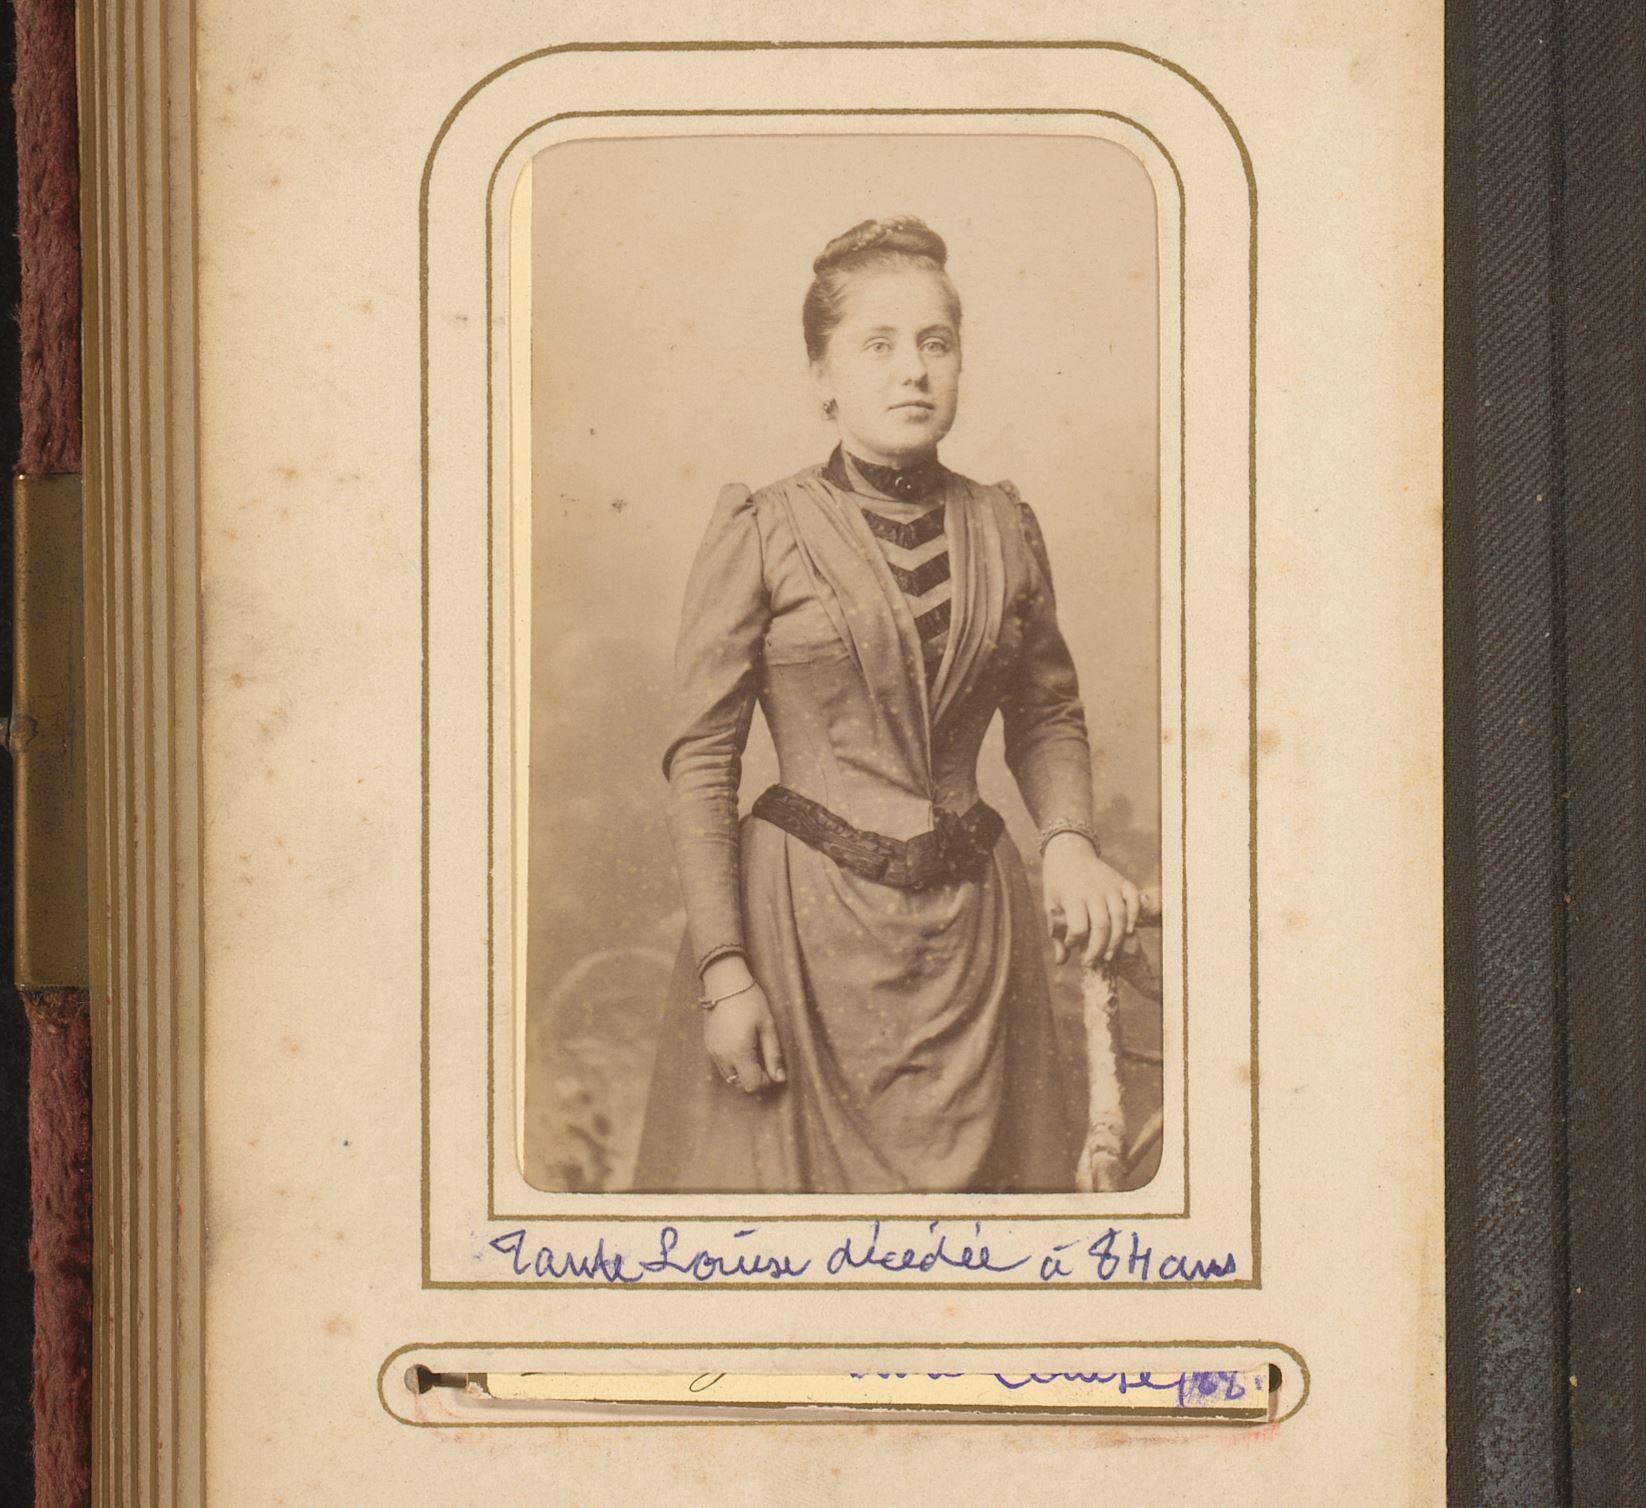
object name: album leaf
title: Portret van een jonge vrouw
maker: christian meyer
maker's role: fotograaf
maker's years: 1835-1910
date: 1860-1900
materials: cardboard, photographic support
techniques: albumen print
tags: adolescent, young woman, maiden, historical persons, standing figure - aa - female human figure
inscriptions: inscription: ‘Photographische Anstalt/ Chr. Meyer/ St. Gallen/ Linsebühl Strasse 84’, annotation: ‘Tante Louise décédé a 84 ans’, annotation: ‘Tante Louise 188.’, annotation: ‘Soeur de maman’